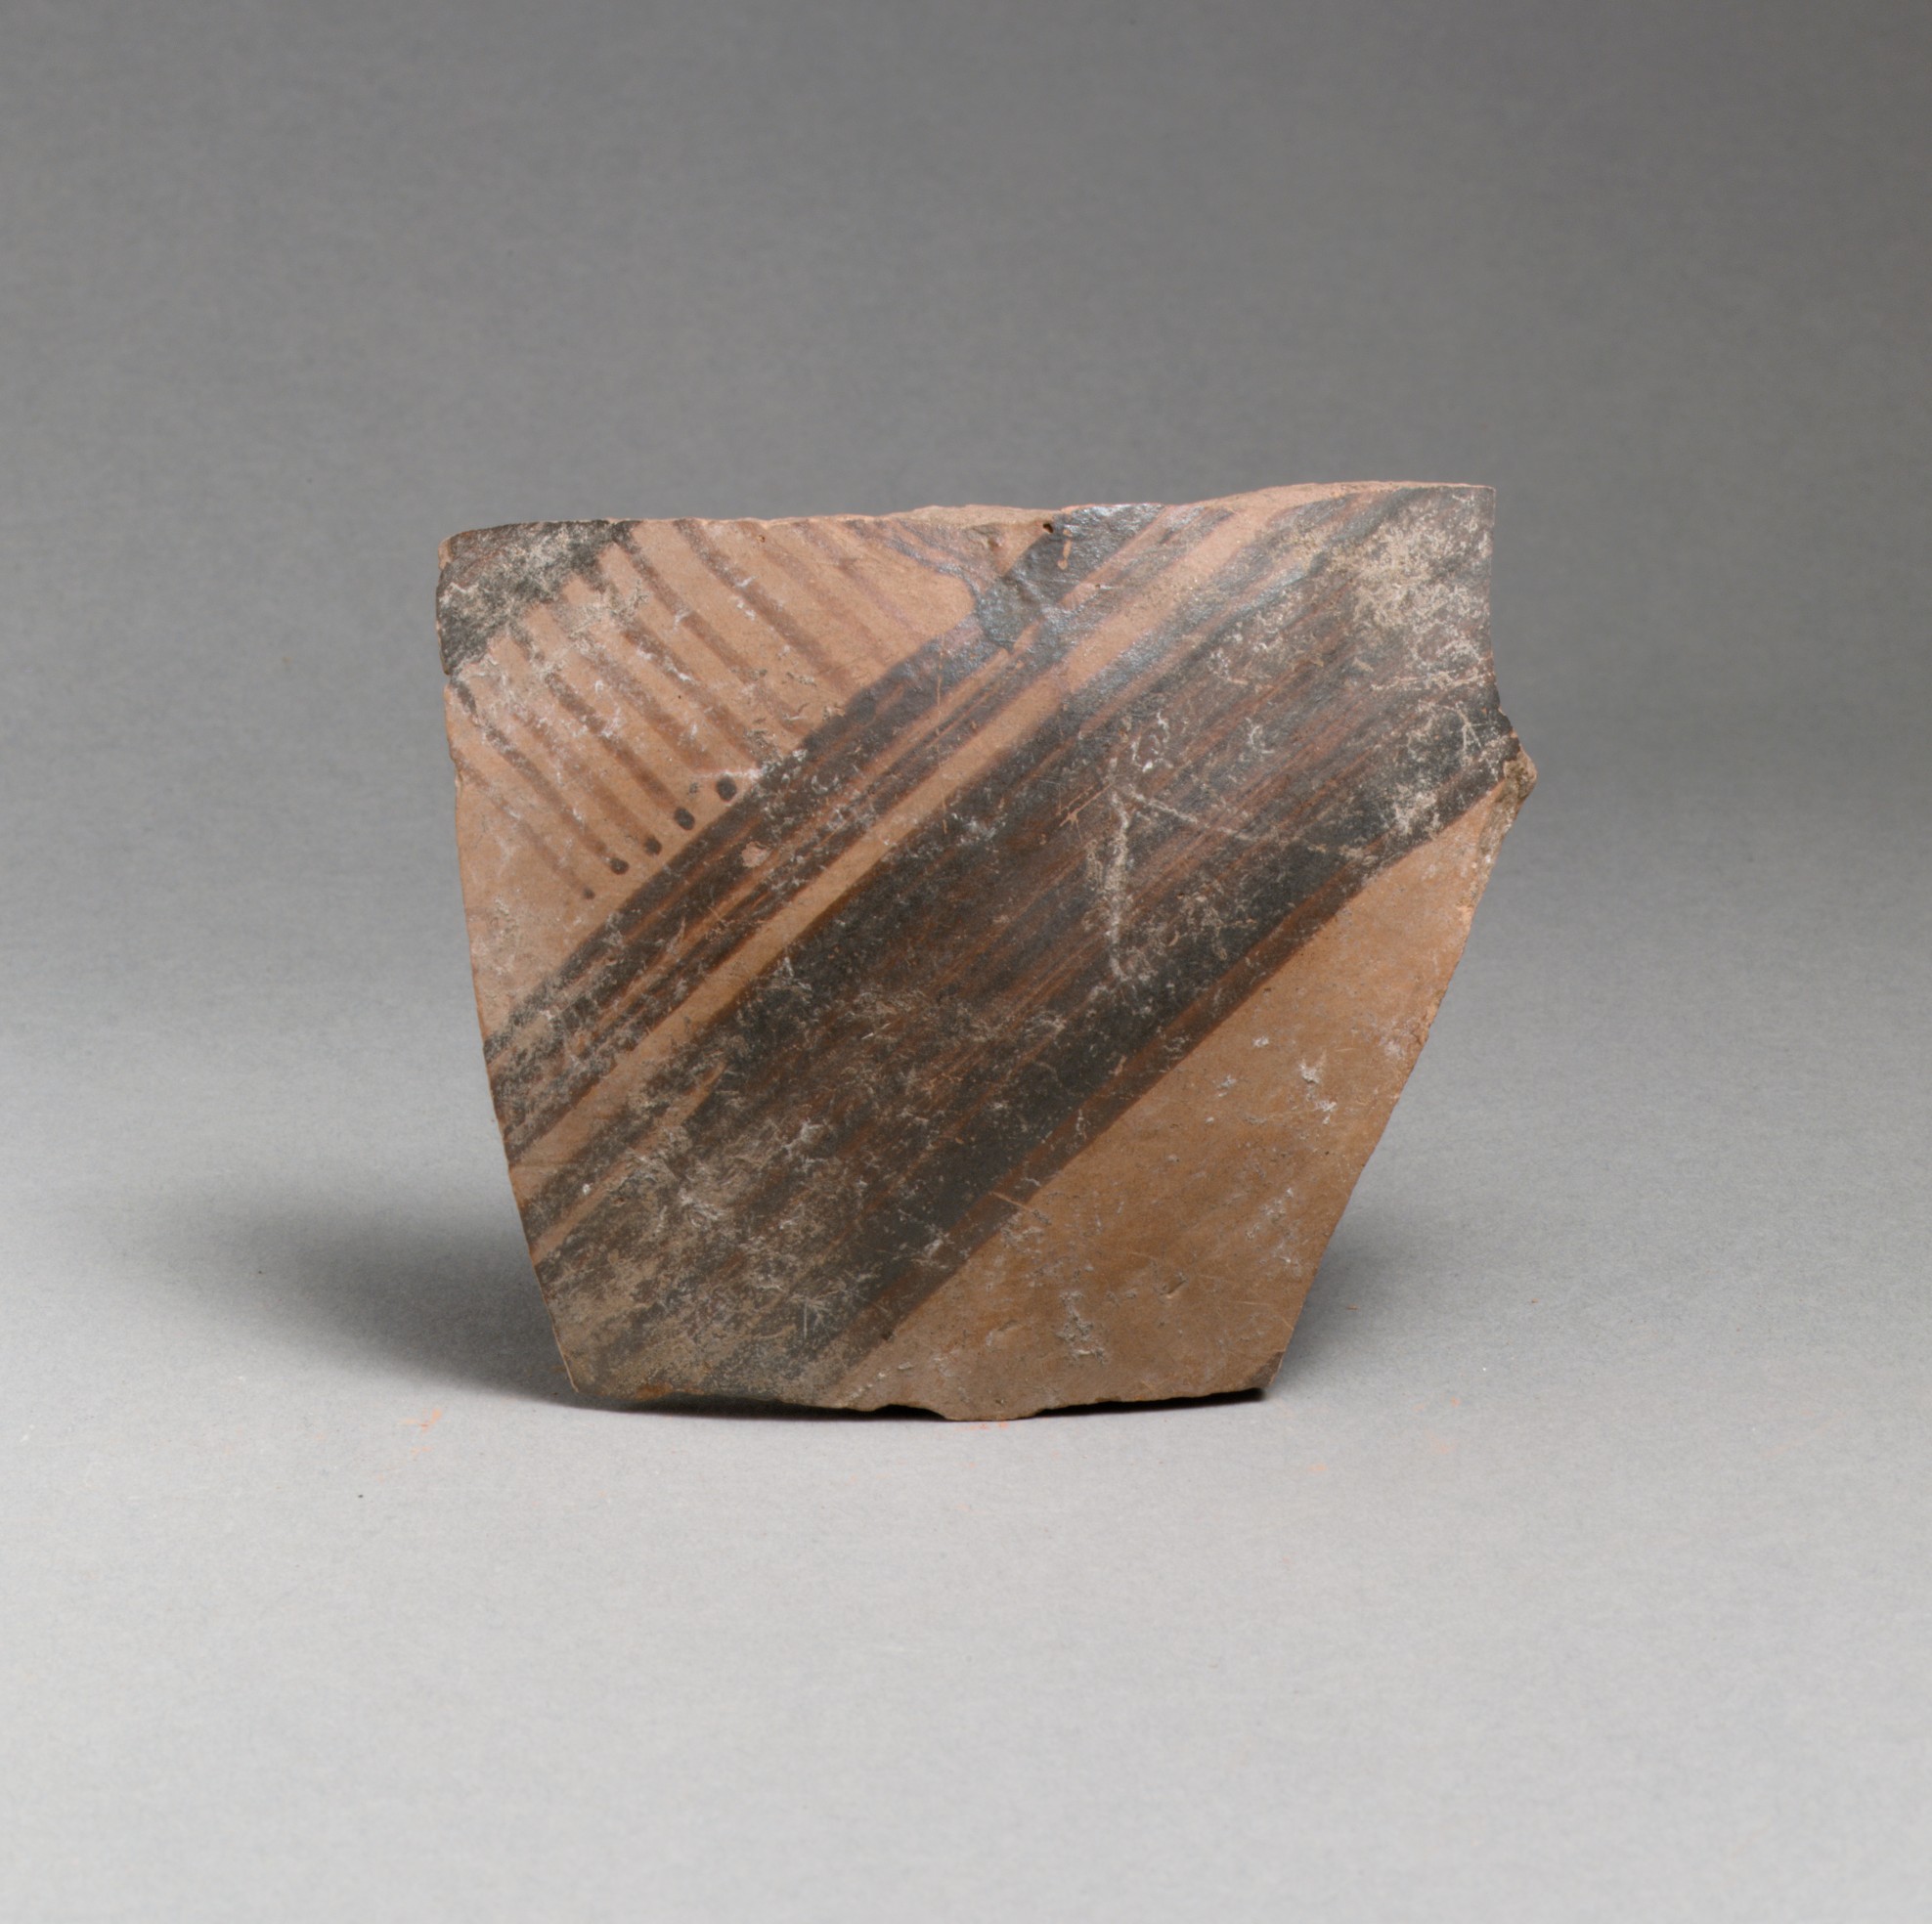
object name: vase fragment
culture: greek or lydian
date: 1050-700 BCE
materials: terracotta